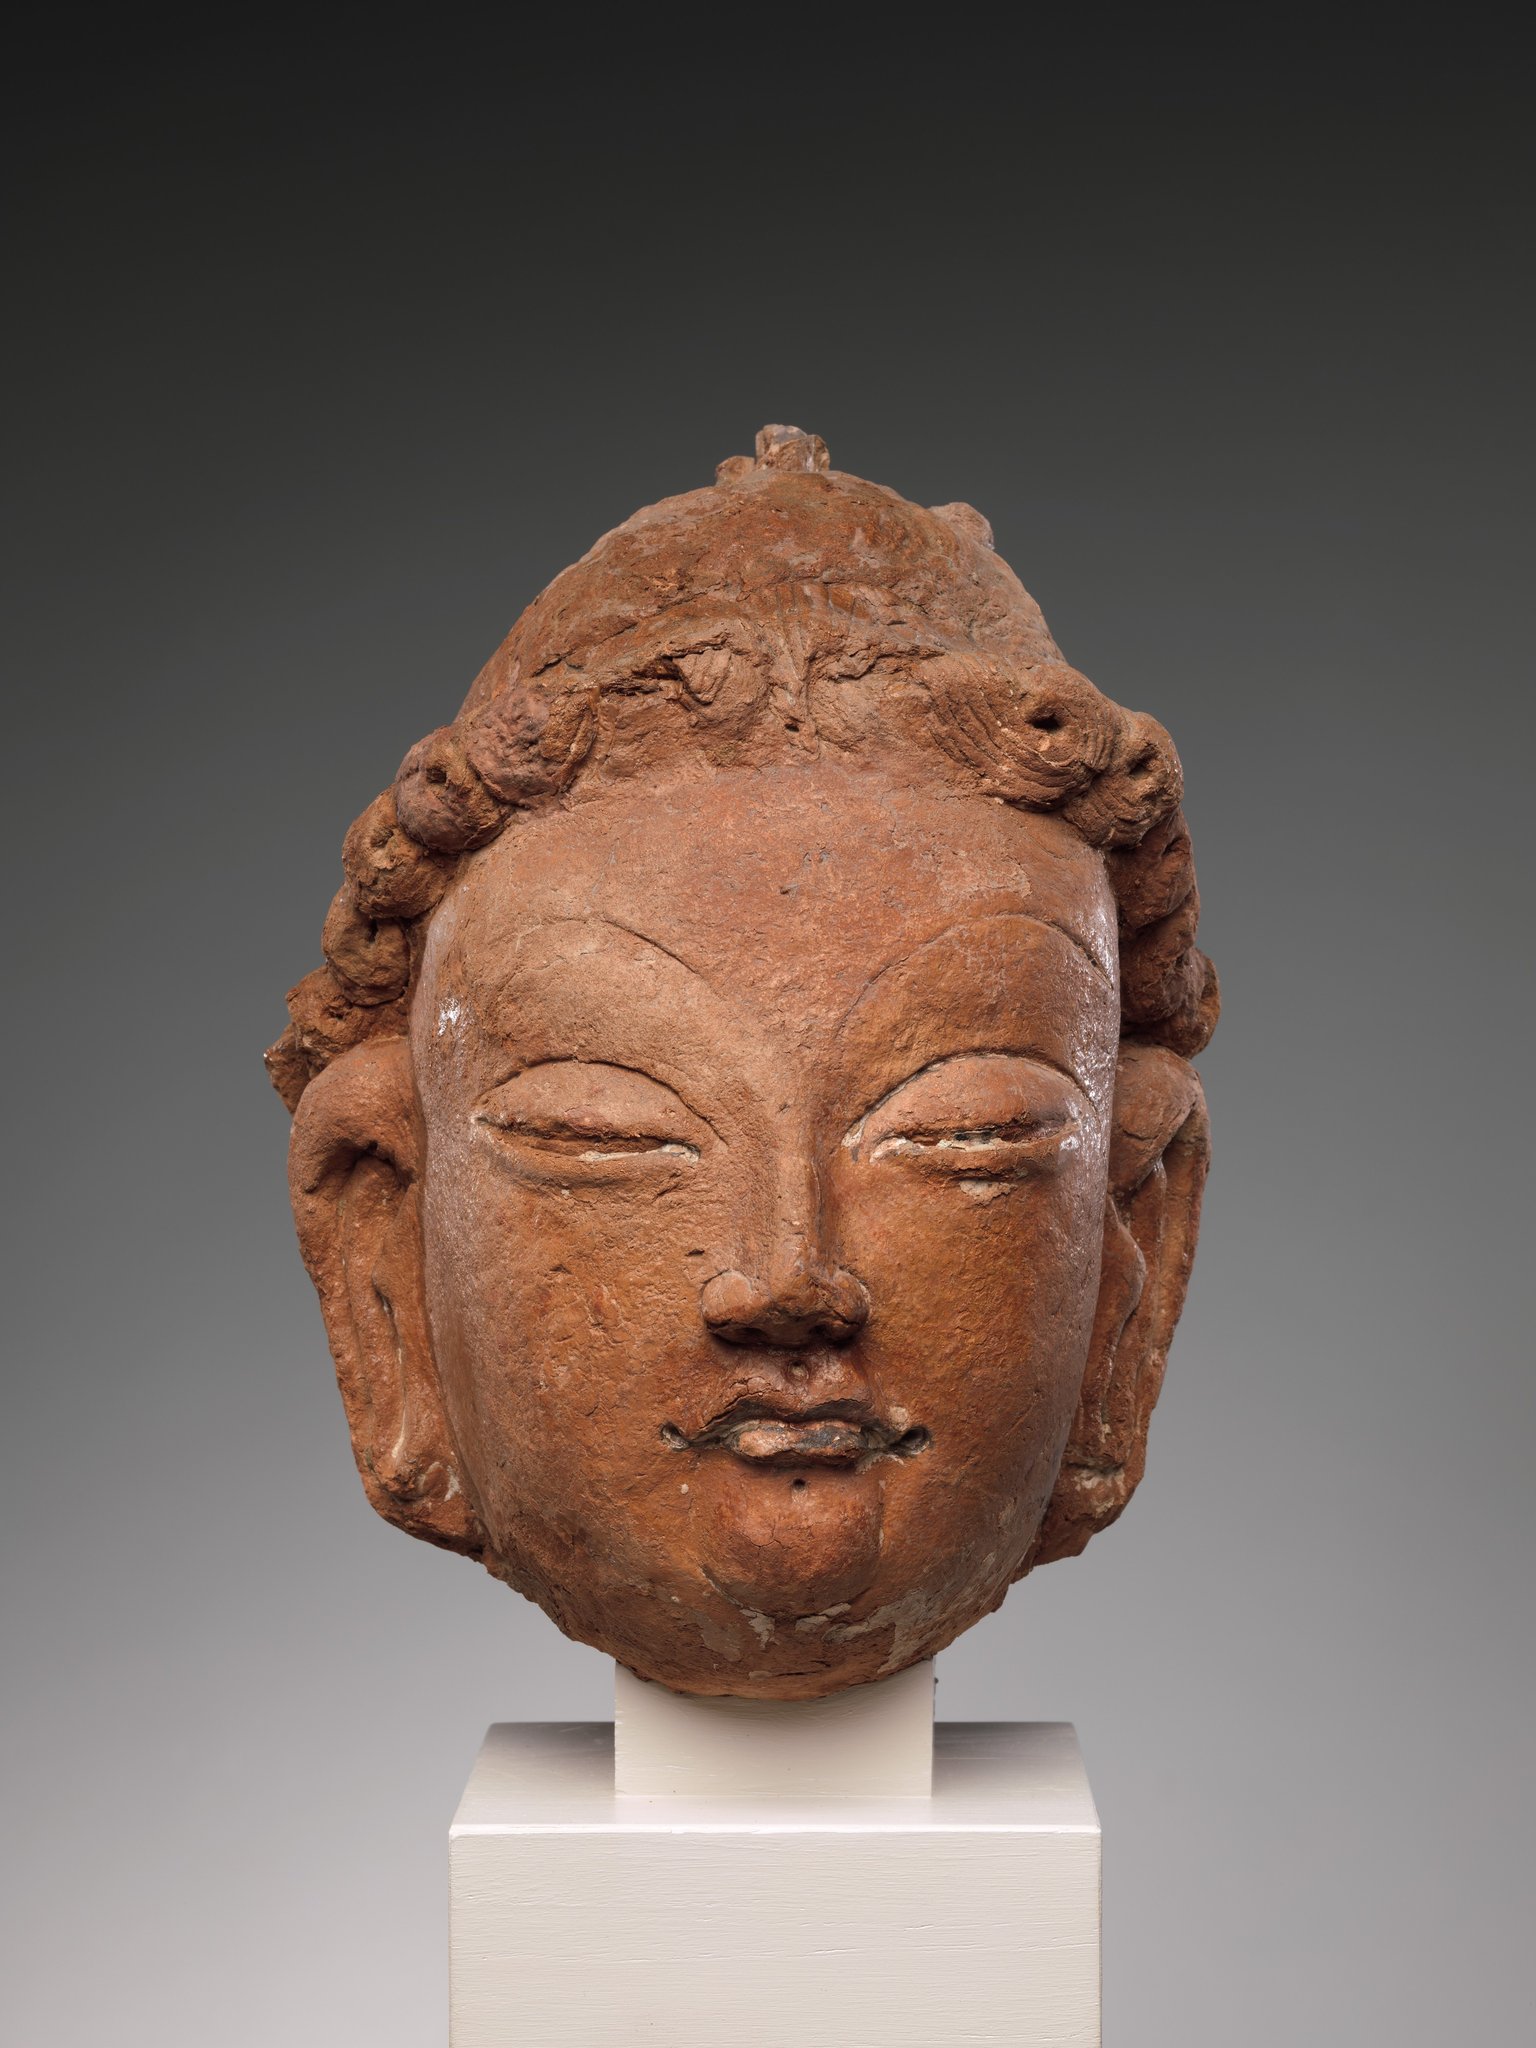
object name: head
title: Head of a Bodhisattva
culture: chinese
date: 501-700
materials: clay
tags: heads,buddhism,bodhisattvas